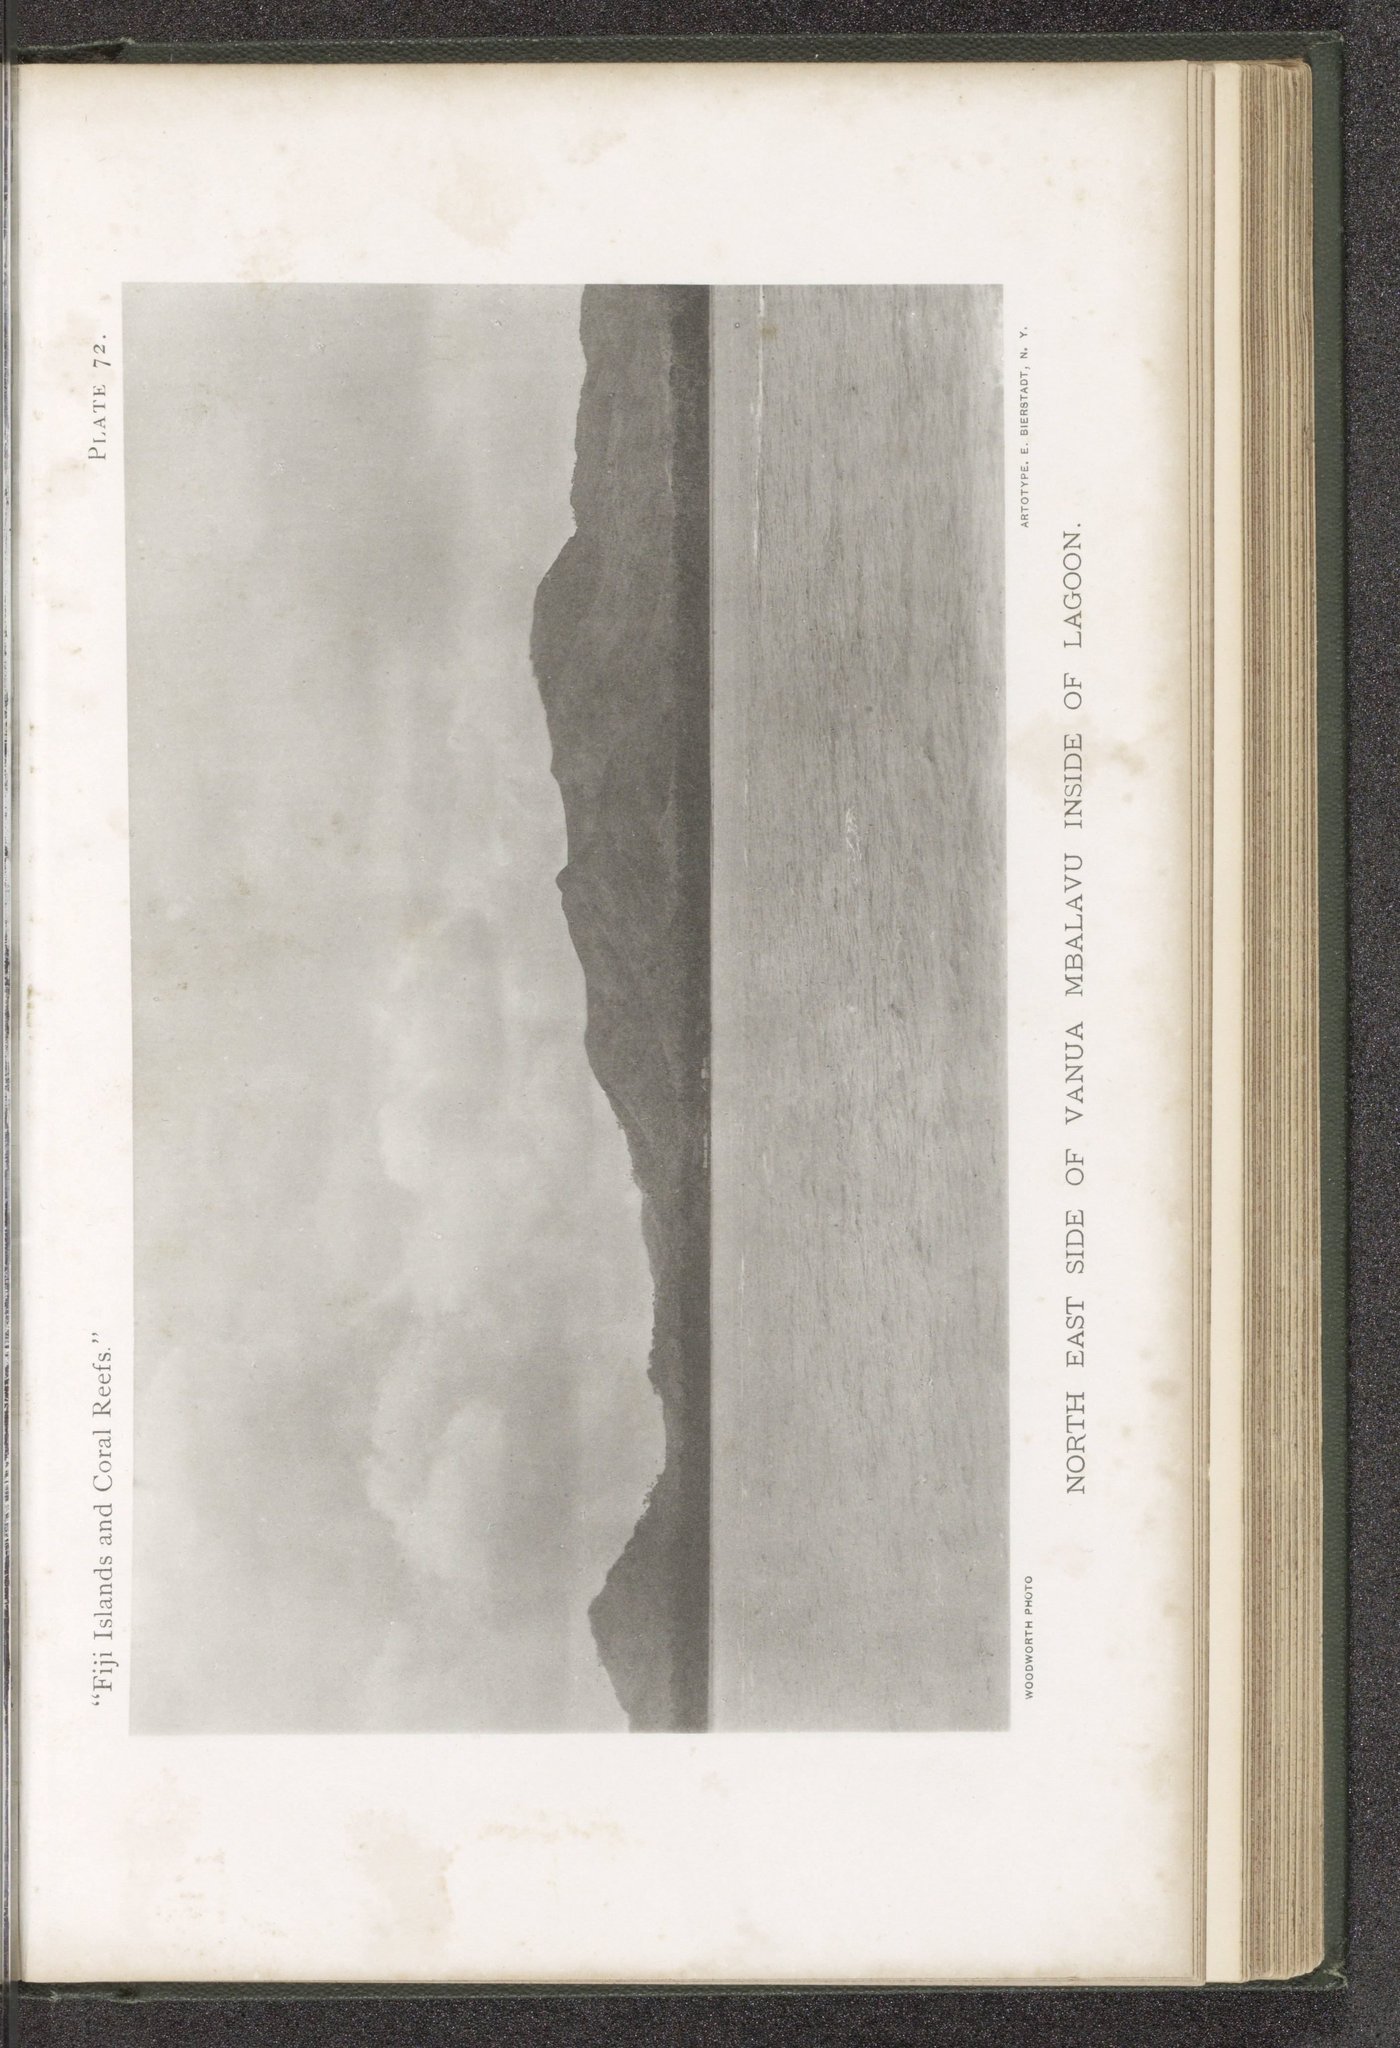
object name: photomechanical print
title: Gezicht op de noordoostkant van Vanua Balavu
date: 1885-1899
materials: paper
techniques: photograph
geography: new york city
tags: island, haff, lagoon created by sand, shingle bank ~ coast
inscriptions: name: ‘Artotype, E. Bierstadt, N. Y.’, number: ‘Plate 72.’, name: ‘Woodworth Photo’